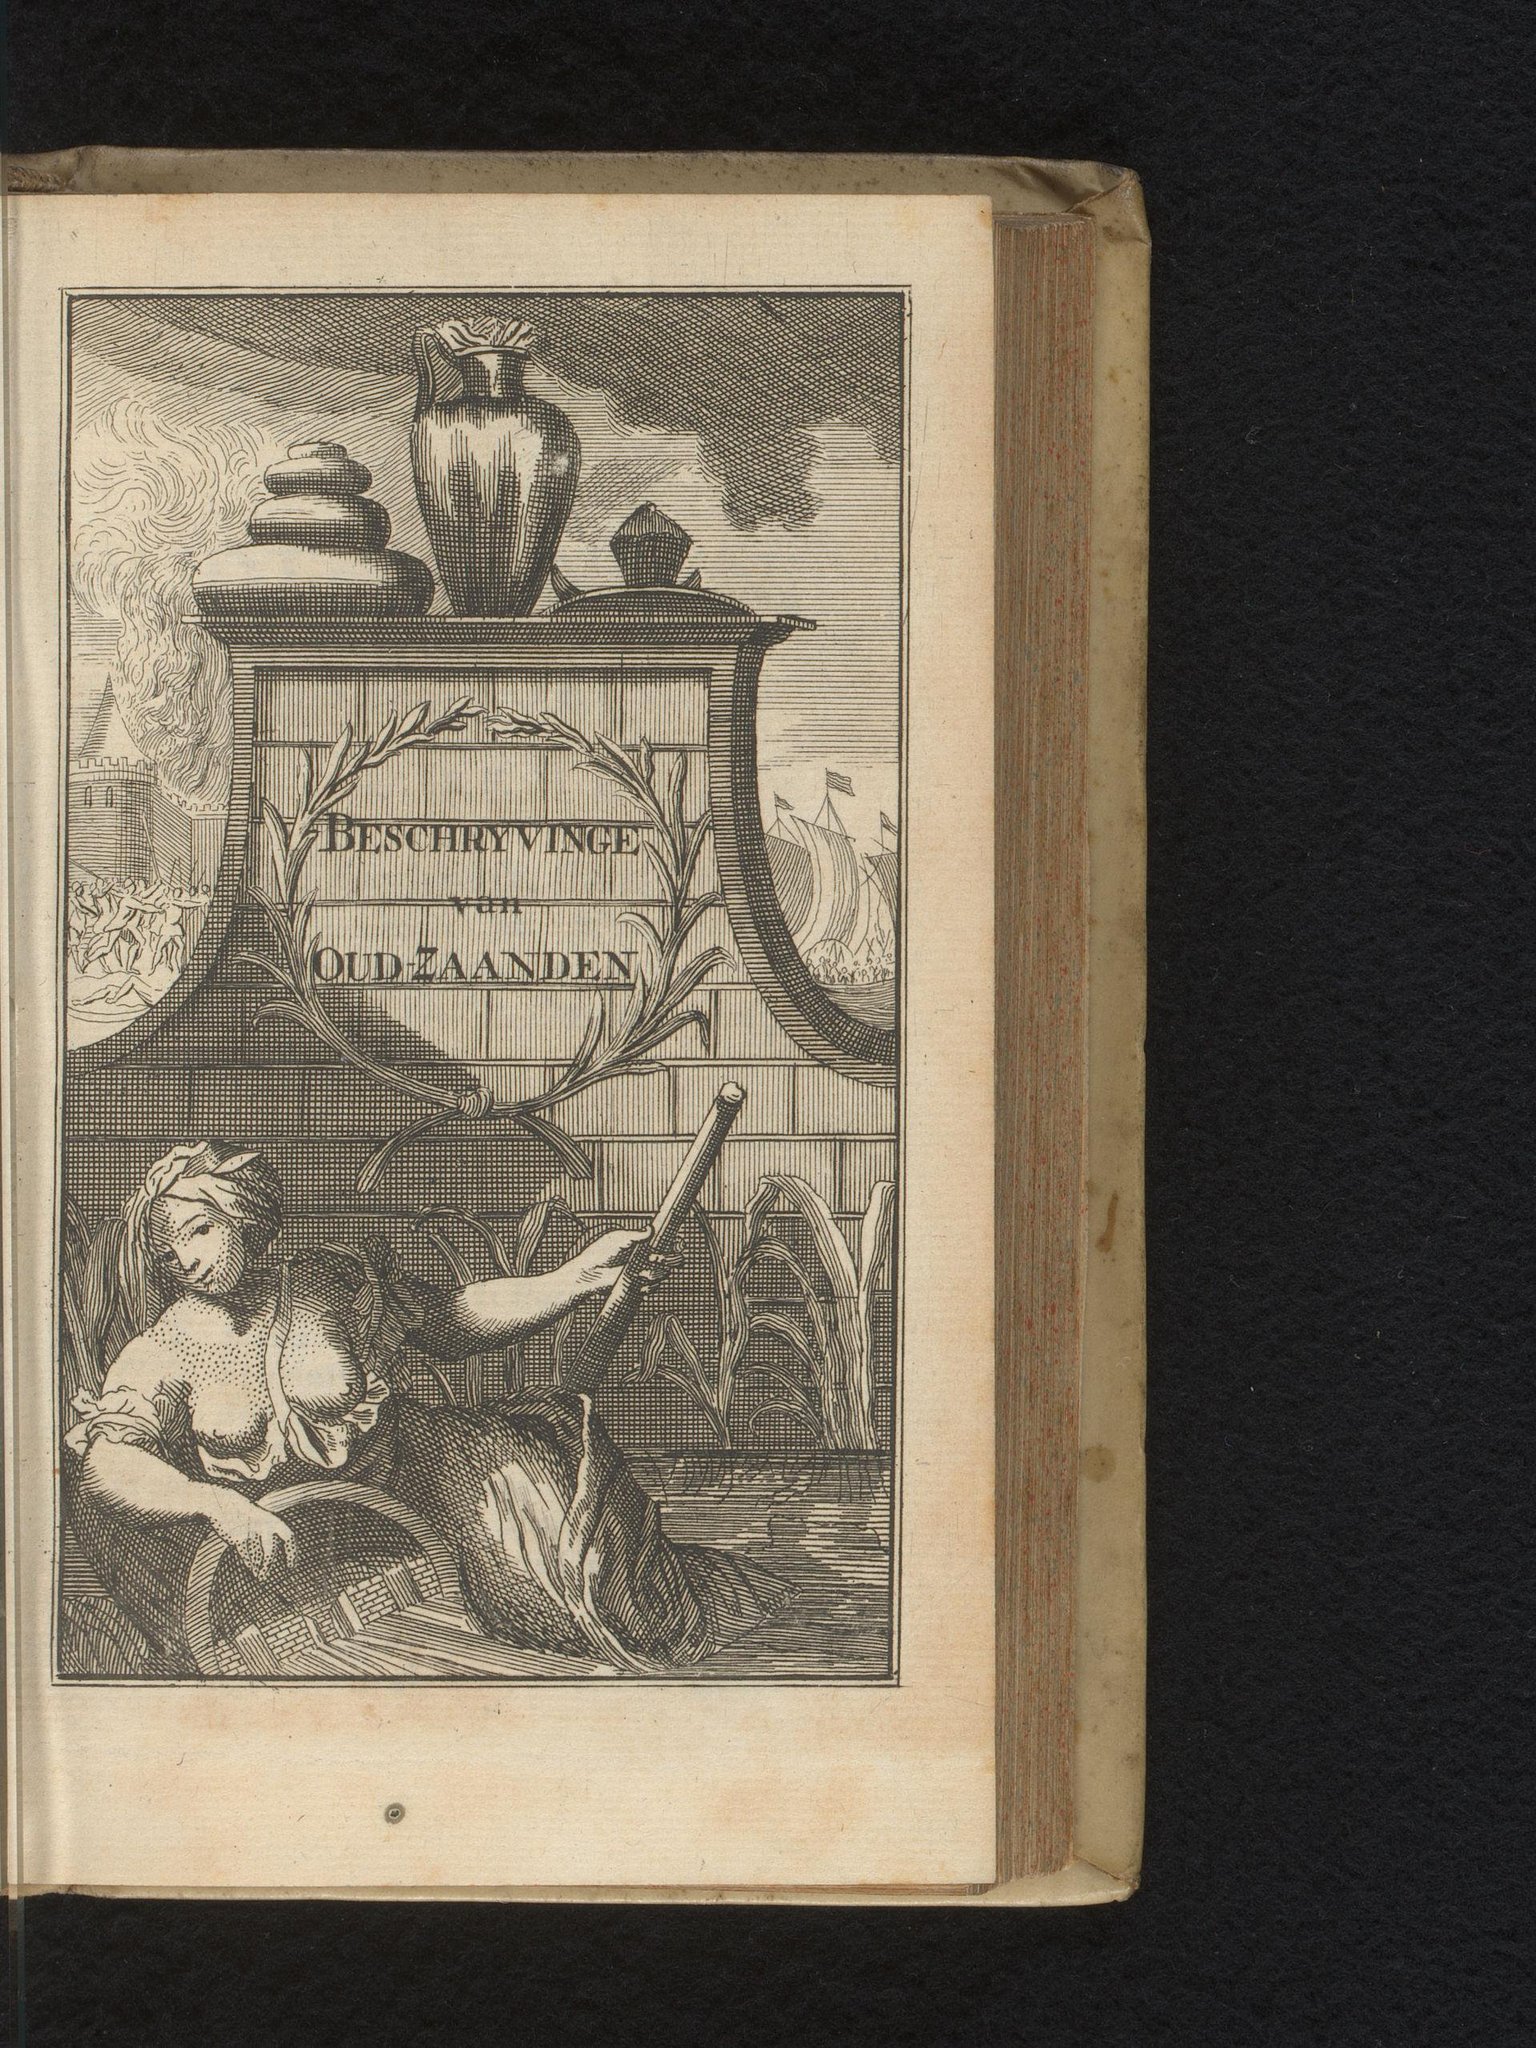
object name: print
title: Beschryvinge van Oud-Zaanden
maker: pieter van den berge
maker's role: draughtsman, print maker, printer, publisher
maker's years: 1659-1737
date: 1700-1702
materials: paper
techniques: etching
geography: northern netherlands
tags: river personified (with name)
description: Illustratie in: H. Soeteboom, Oud-heden van Zaan-land, Stavoren, Vronen en Waterland : deze laatste druk ... met nodige aanteekeningen, figuren, en een landkaart verrykt, W. Linnig van Koppenol, Amsterdam 1702, dl. 1, titelprent.